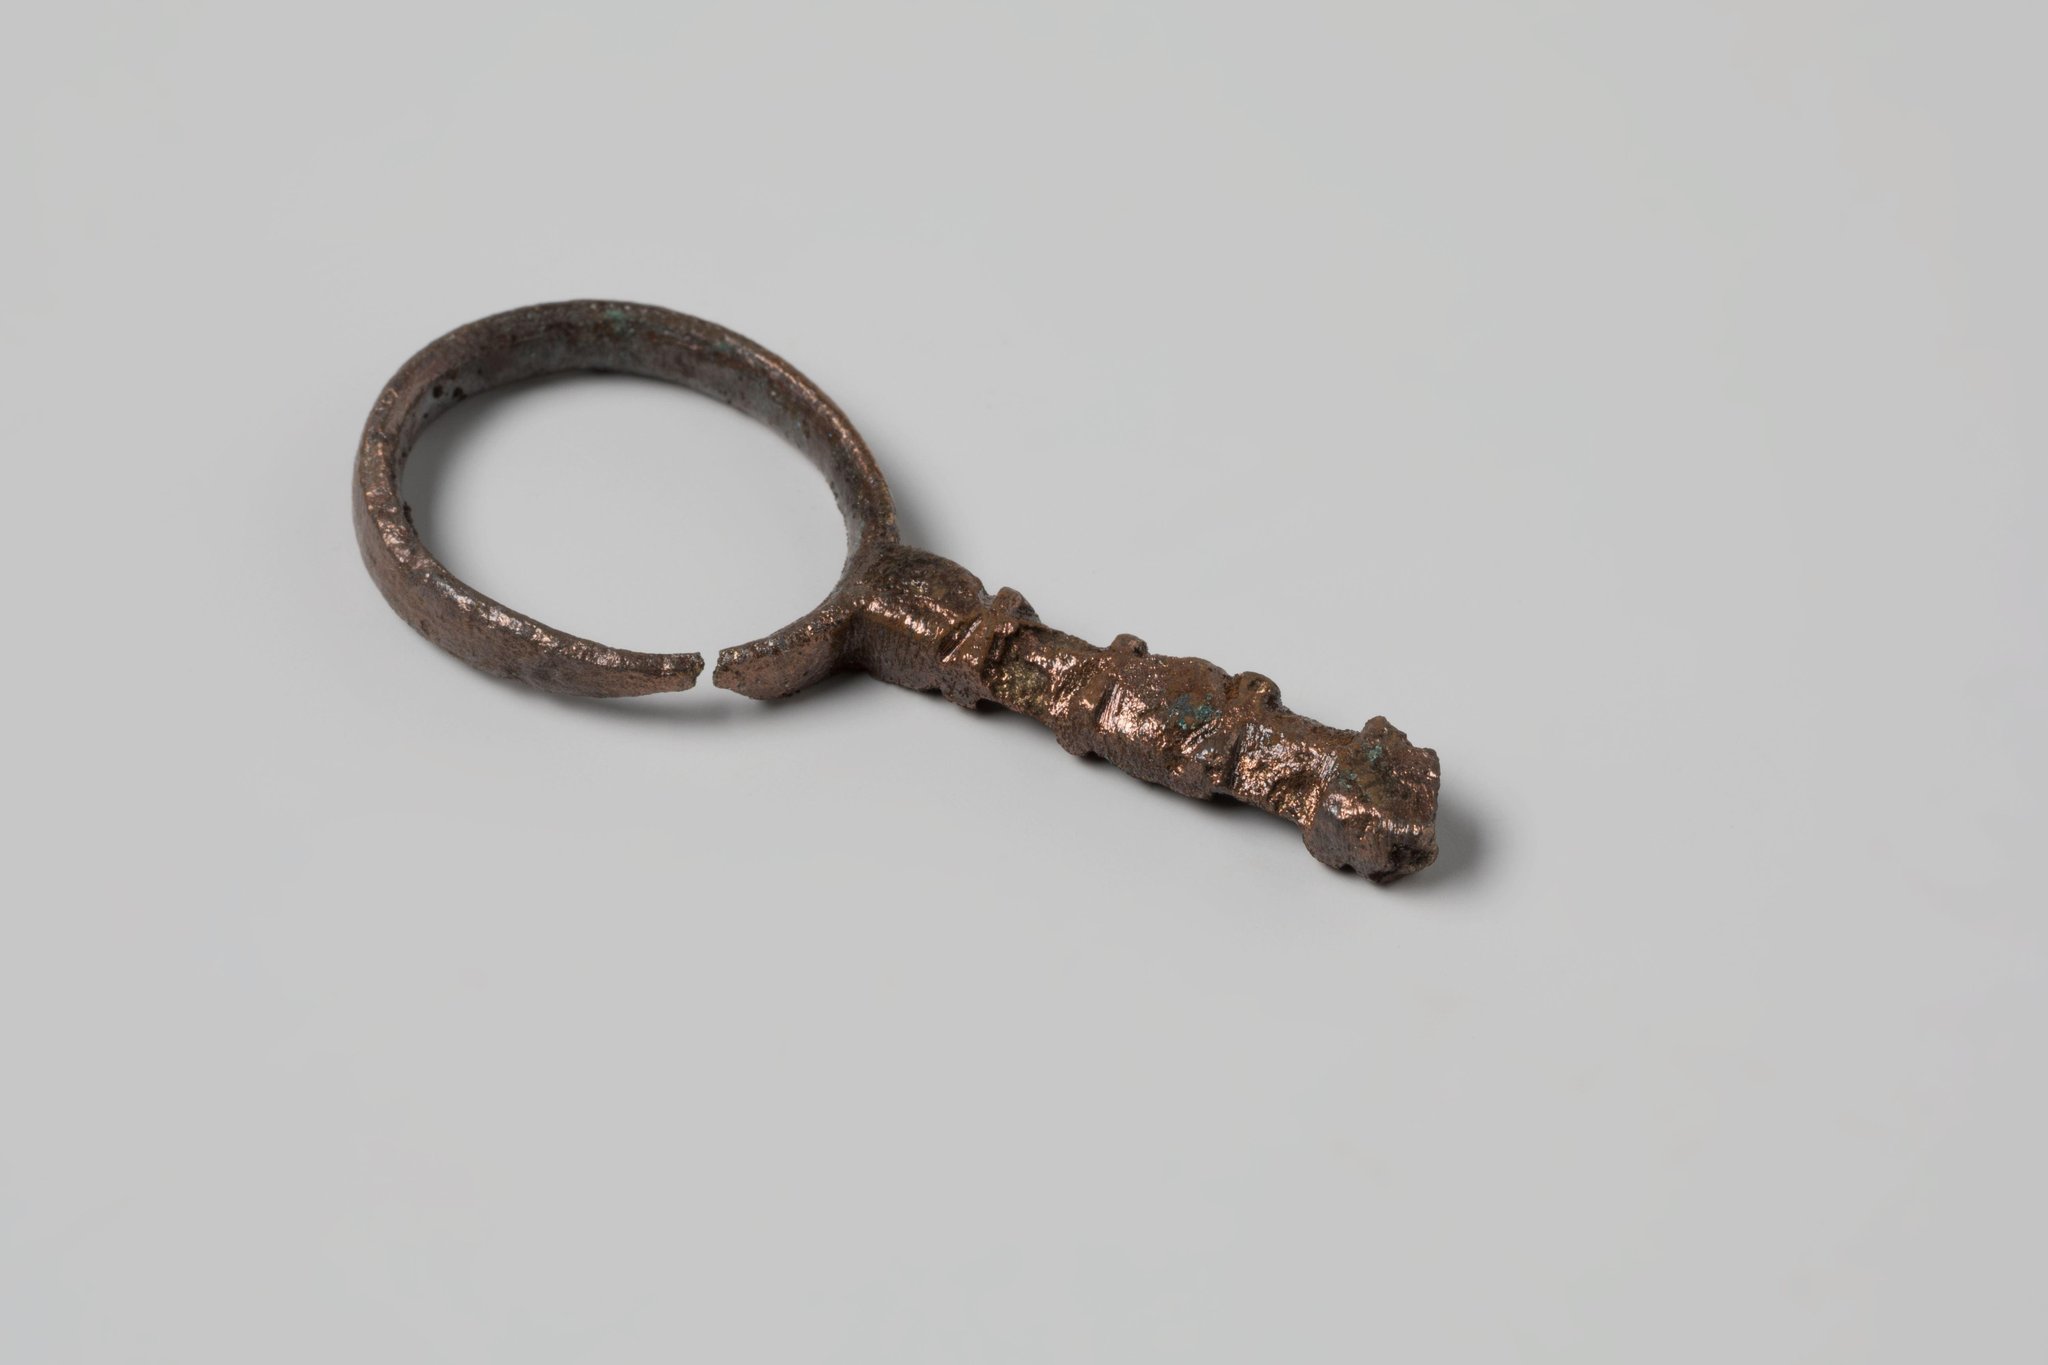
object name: pin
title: Speld uit het wrak van de Oost-Indiëvaarder Hollandia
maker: Anonymous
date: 1700-1743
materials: copper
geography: netherlands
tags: verenigde oostindische compagnie, hollandia (schip), annet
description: Tools and instruments, sewing and sailmaking, pin; fragm: fragm of shaft with bow: bow, id. NG 1980-27H3265.